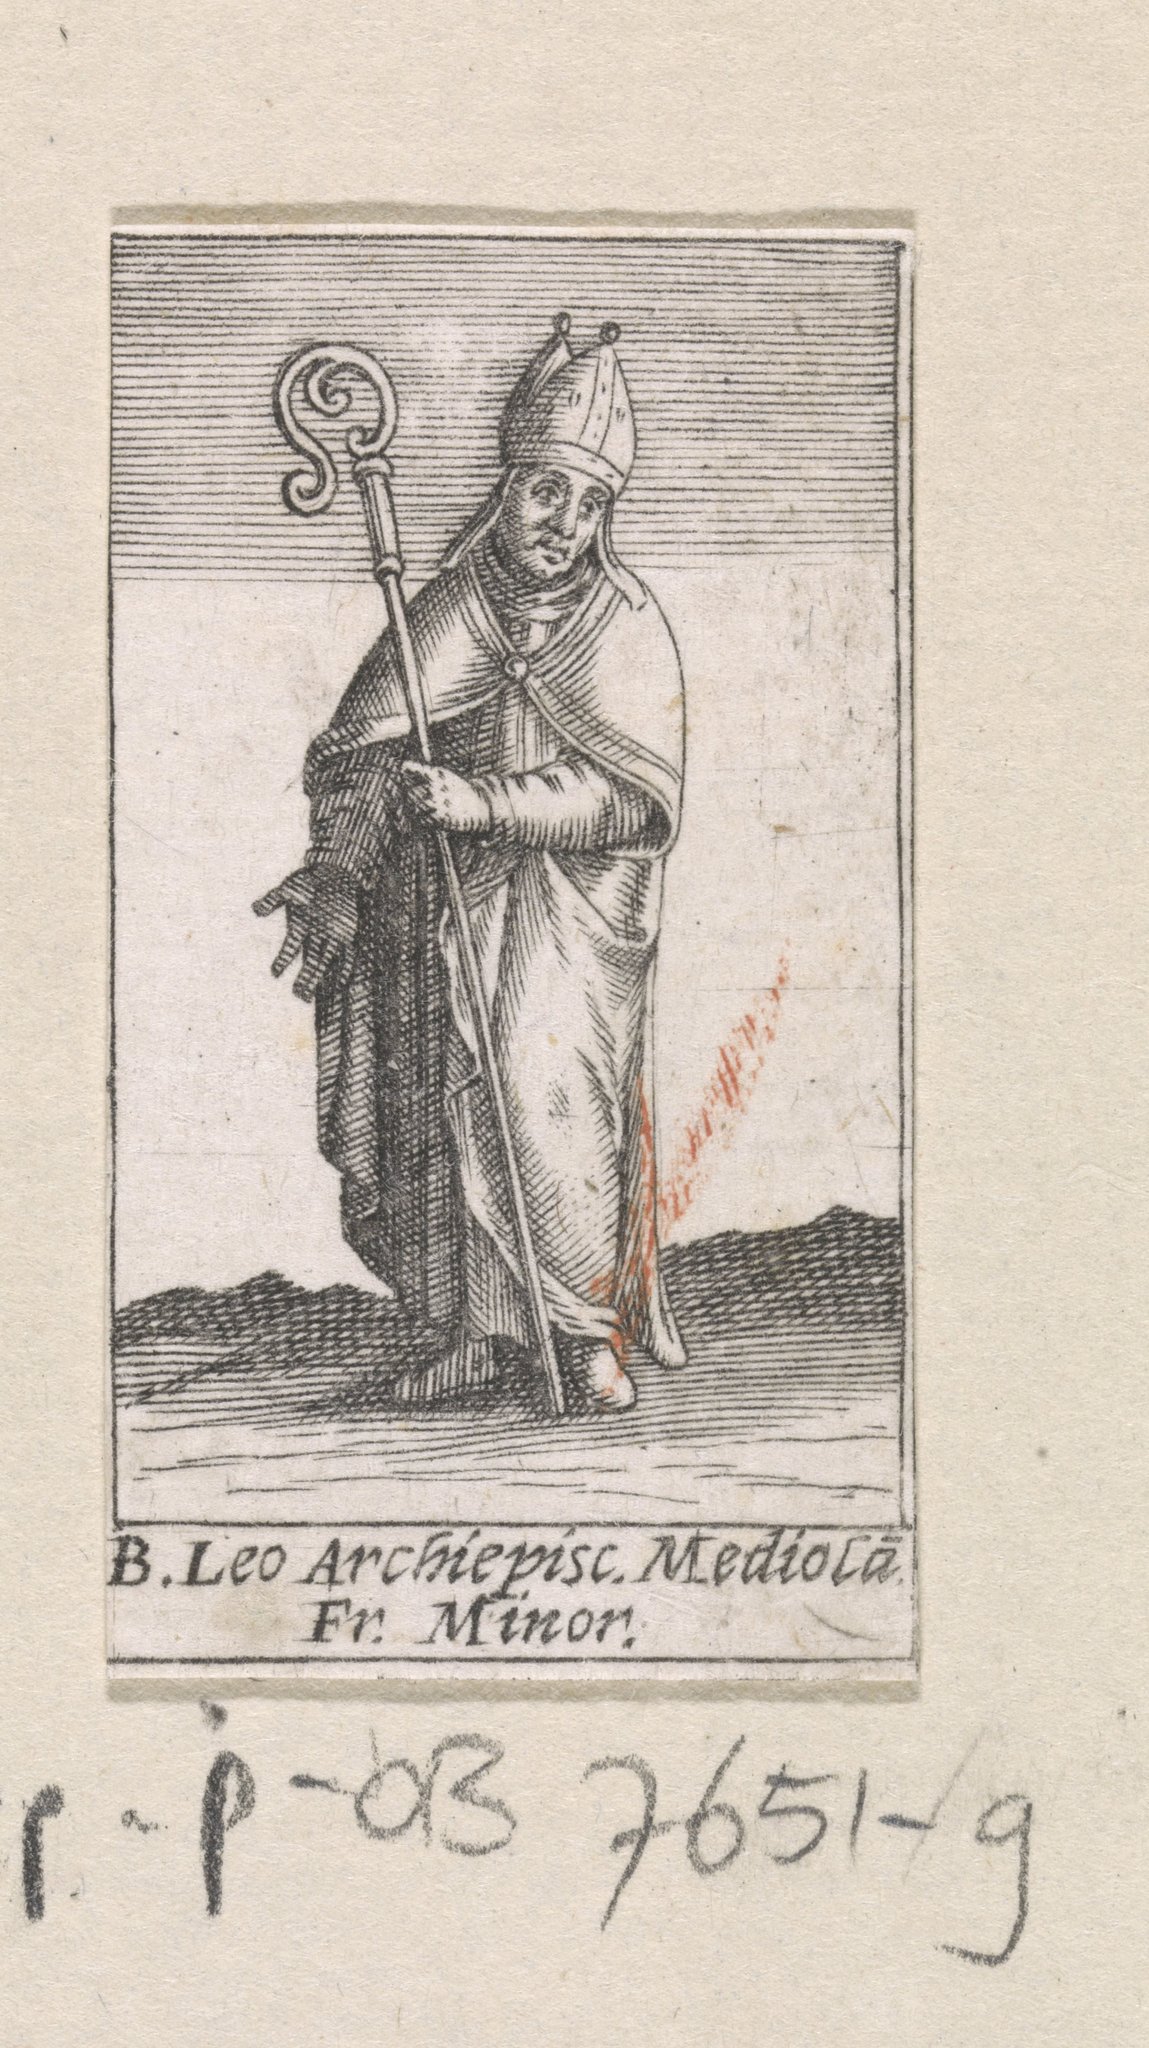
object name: print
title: Portret van een onbekende aartsbisschop Leo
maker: Anonymous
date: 1570-1632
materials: paper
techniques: engraving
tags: archbishop, bishop, etc. (roman catholic), monastic orders, monastic life: franciscans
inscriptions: collector's mark: Lugt 240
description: Deze prent vormt samen met RP-P-OB-7651-2 t/m RP-P-OB-7651-11 een lijst rondom RP-P-OB-7609.